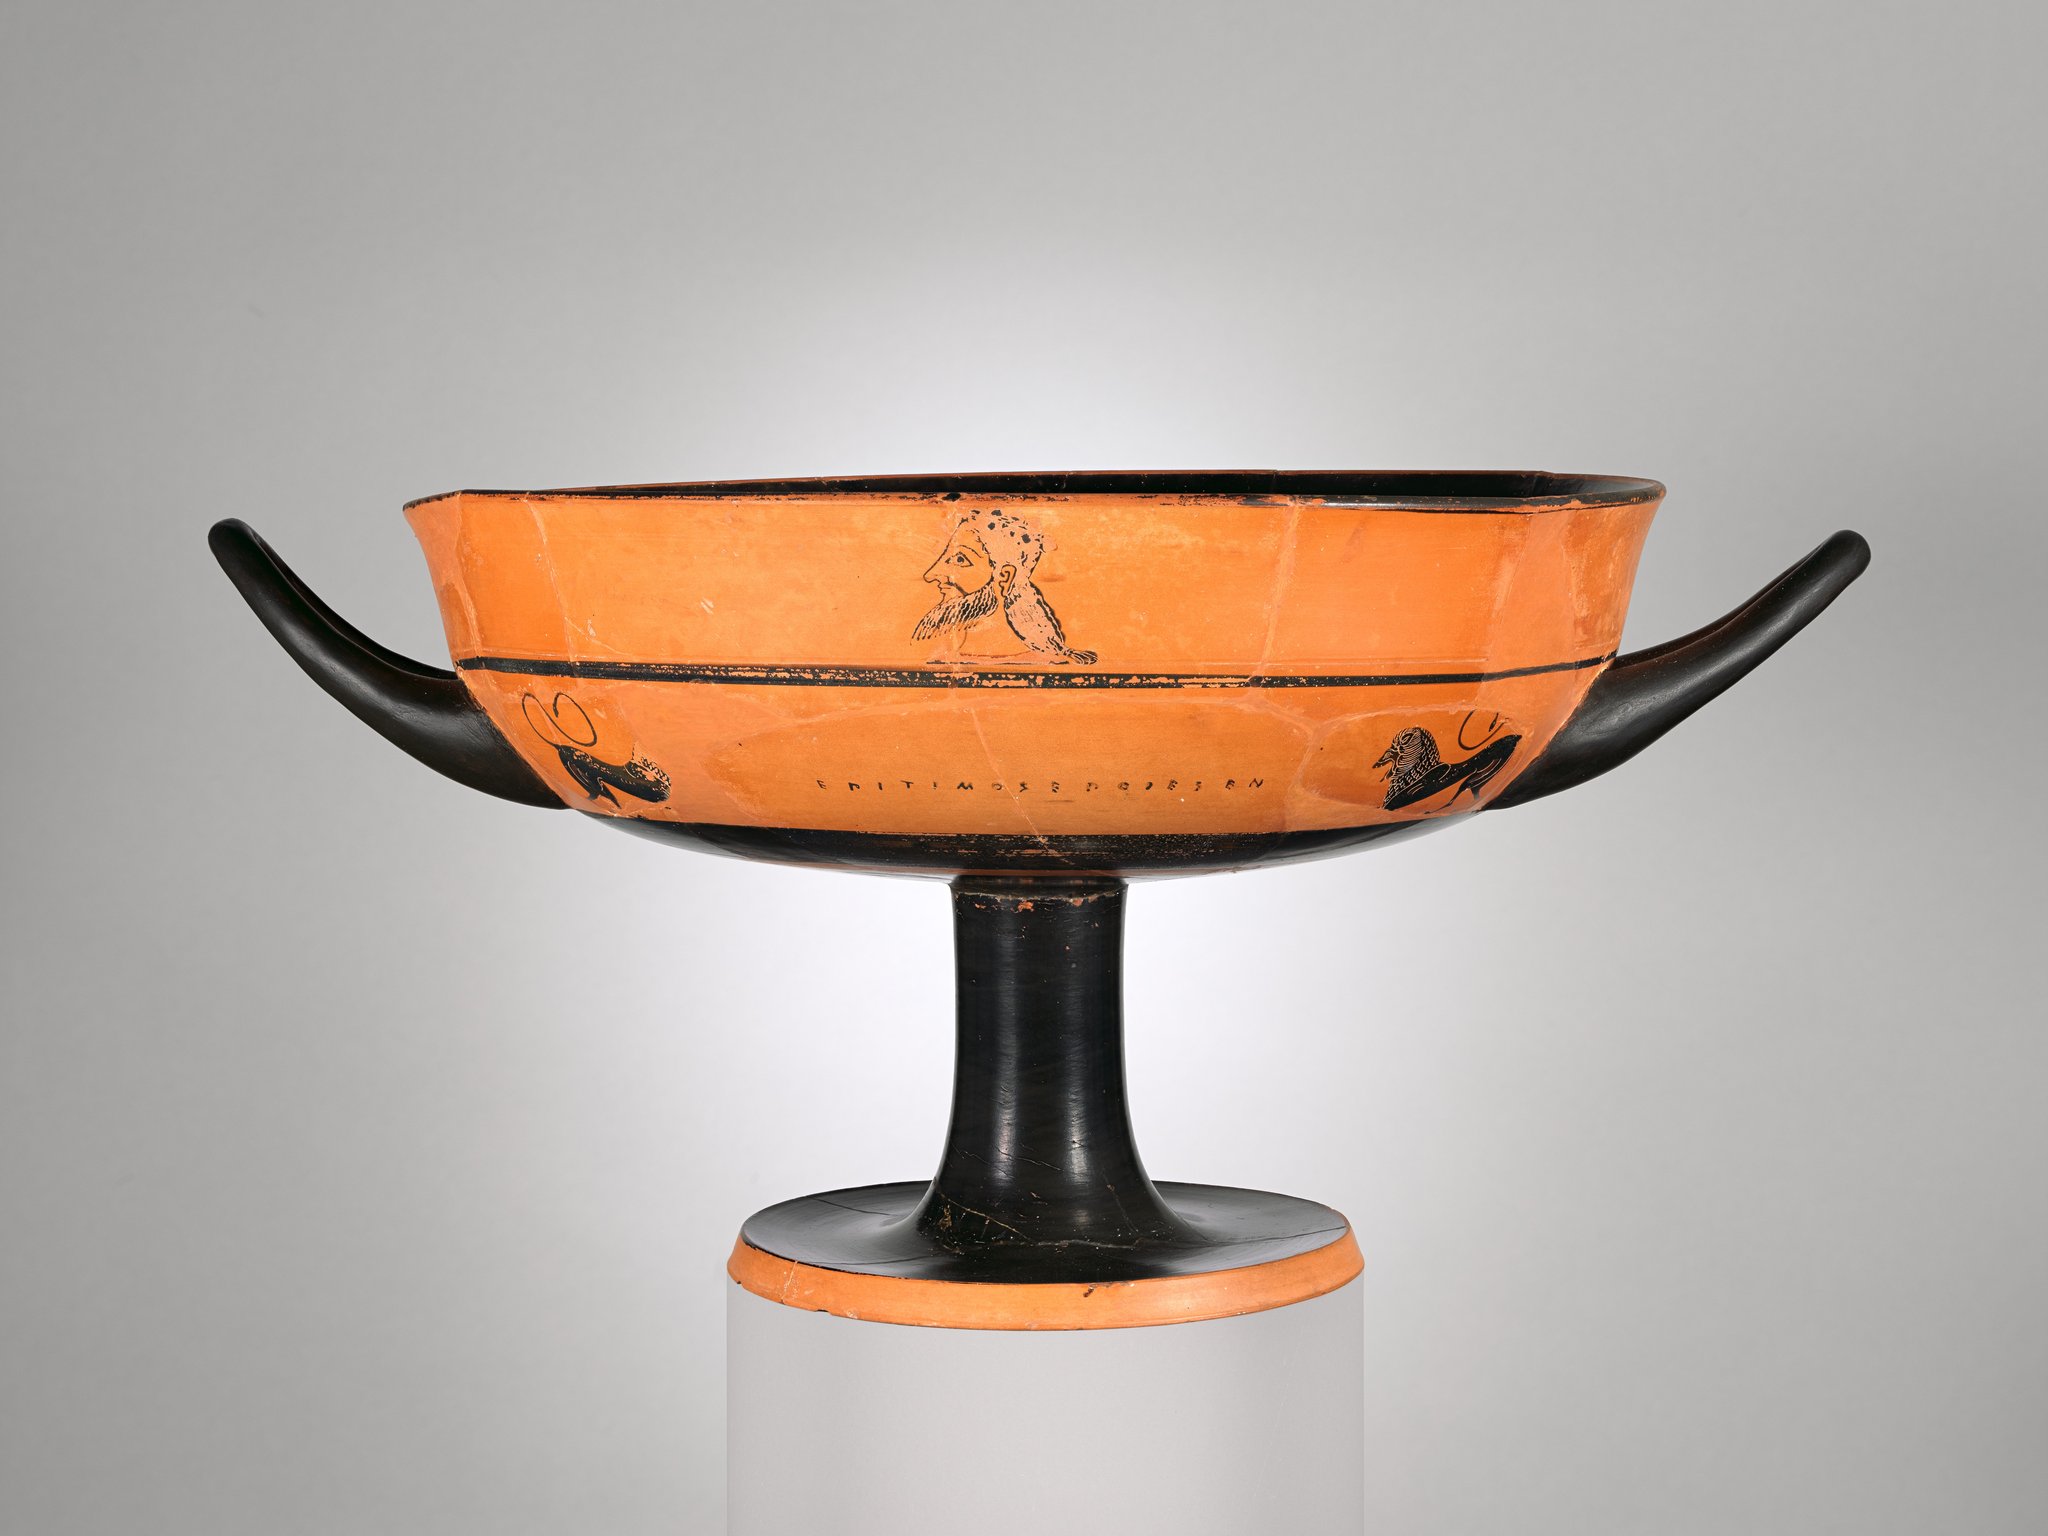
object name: kylix, lip cup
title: Terracotta kylix: lip-cup (drinking cup)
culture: greek, attic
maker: epitimos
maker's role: artist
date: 550-540 BCE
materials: terracotta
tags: horses,warriors